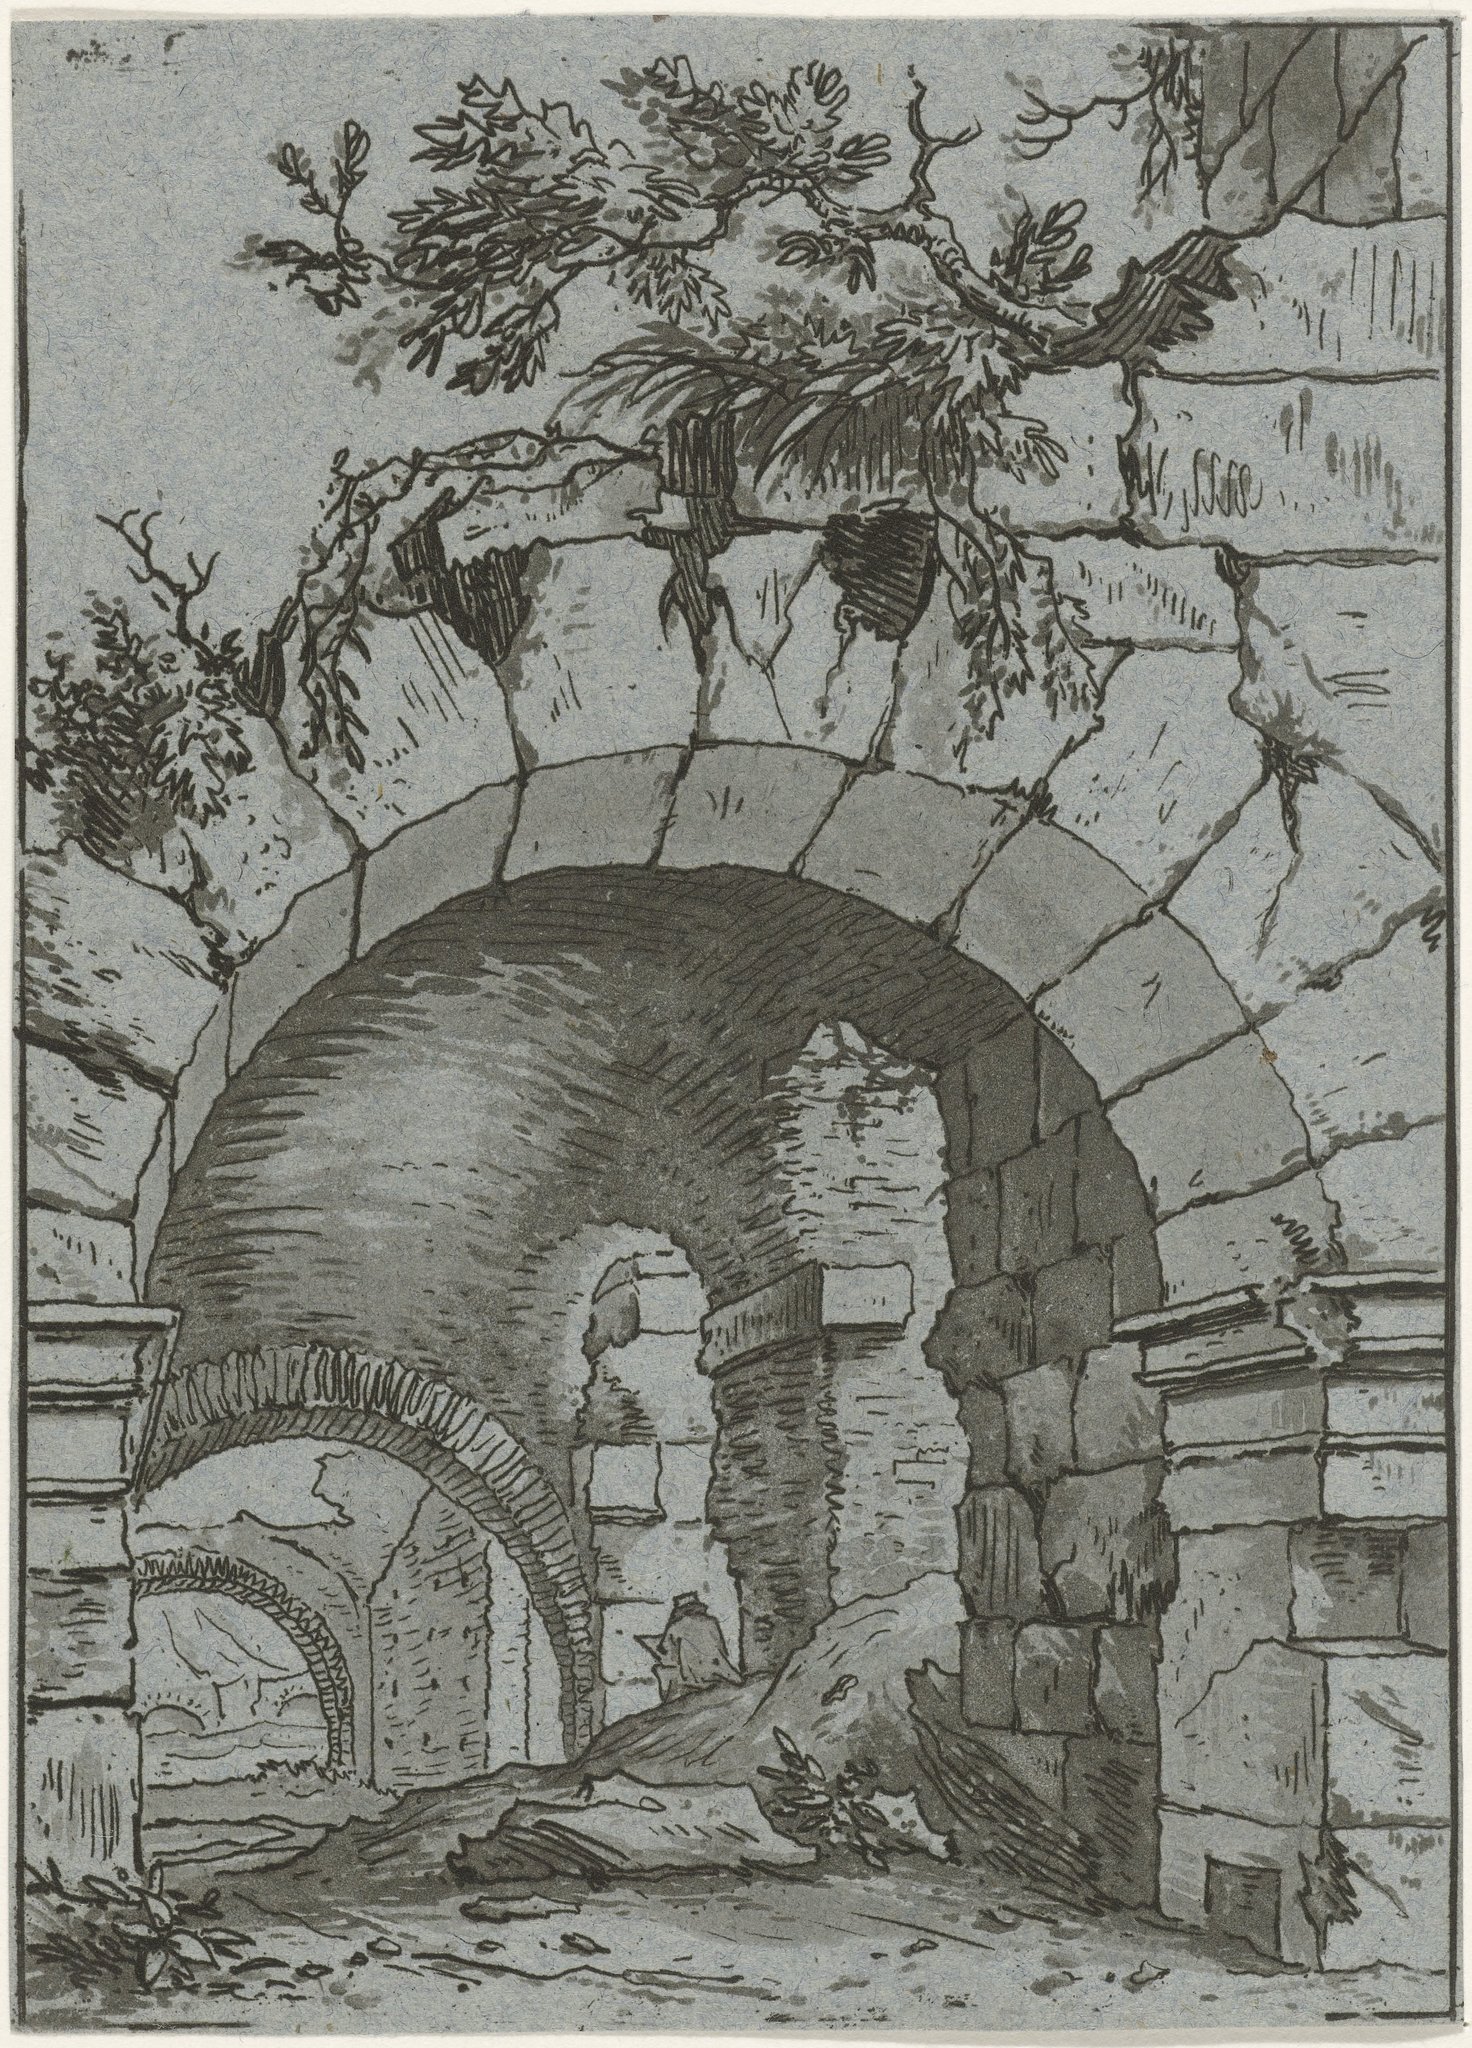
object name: print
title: Tekenaar in het Colosseum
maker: hermanus fock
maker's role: conservator, draughtsman, painter, print maker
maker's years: 1766-1822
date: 1781-1822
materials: paper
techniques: aquatint, etching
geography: amsterdam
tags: ruin of a building ~ architecture (+ artist at work)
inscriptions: collector's mark: Lugt 2228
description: Gezicht op de tongewelven van een ruïne, waar halverwege een persoon met een schetsblad zit.